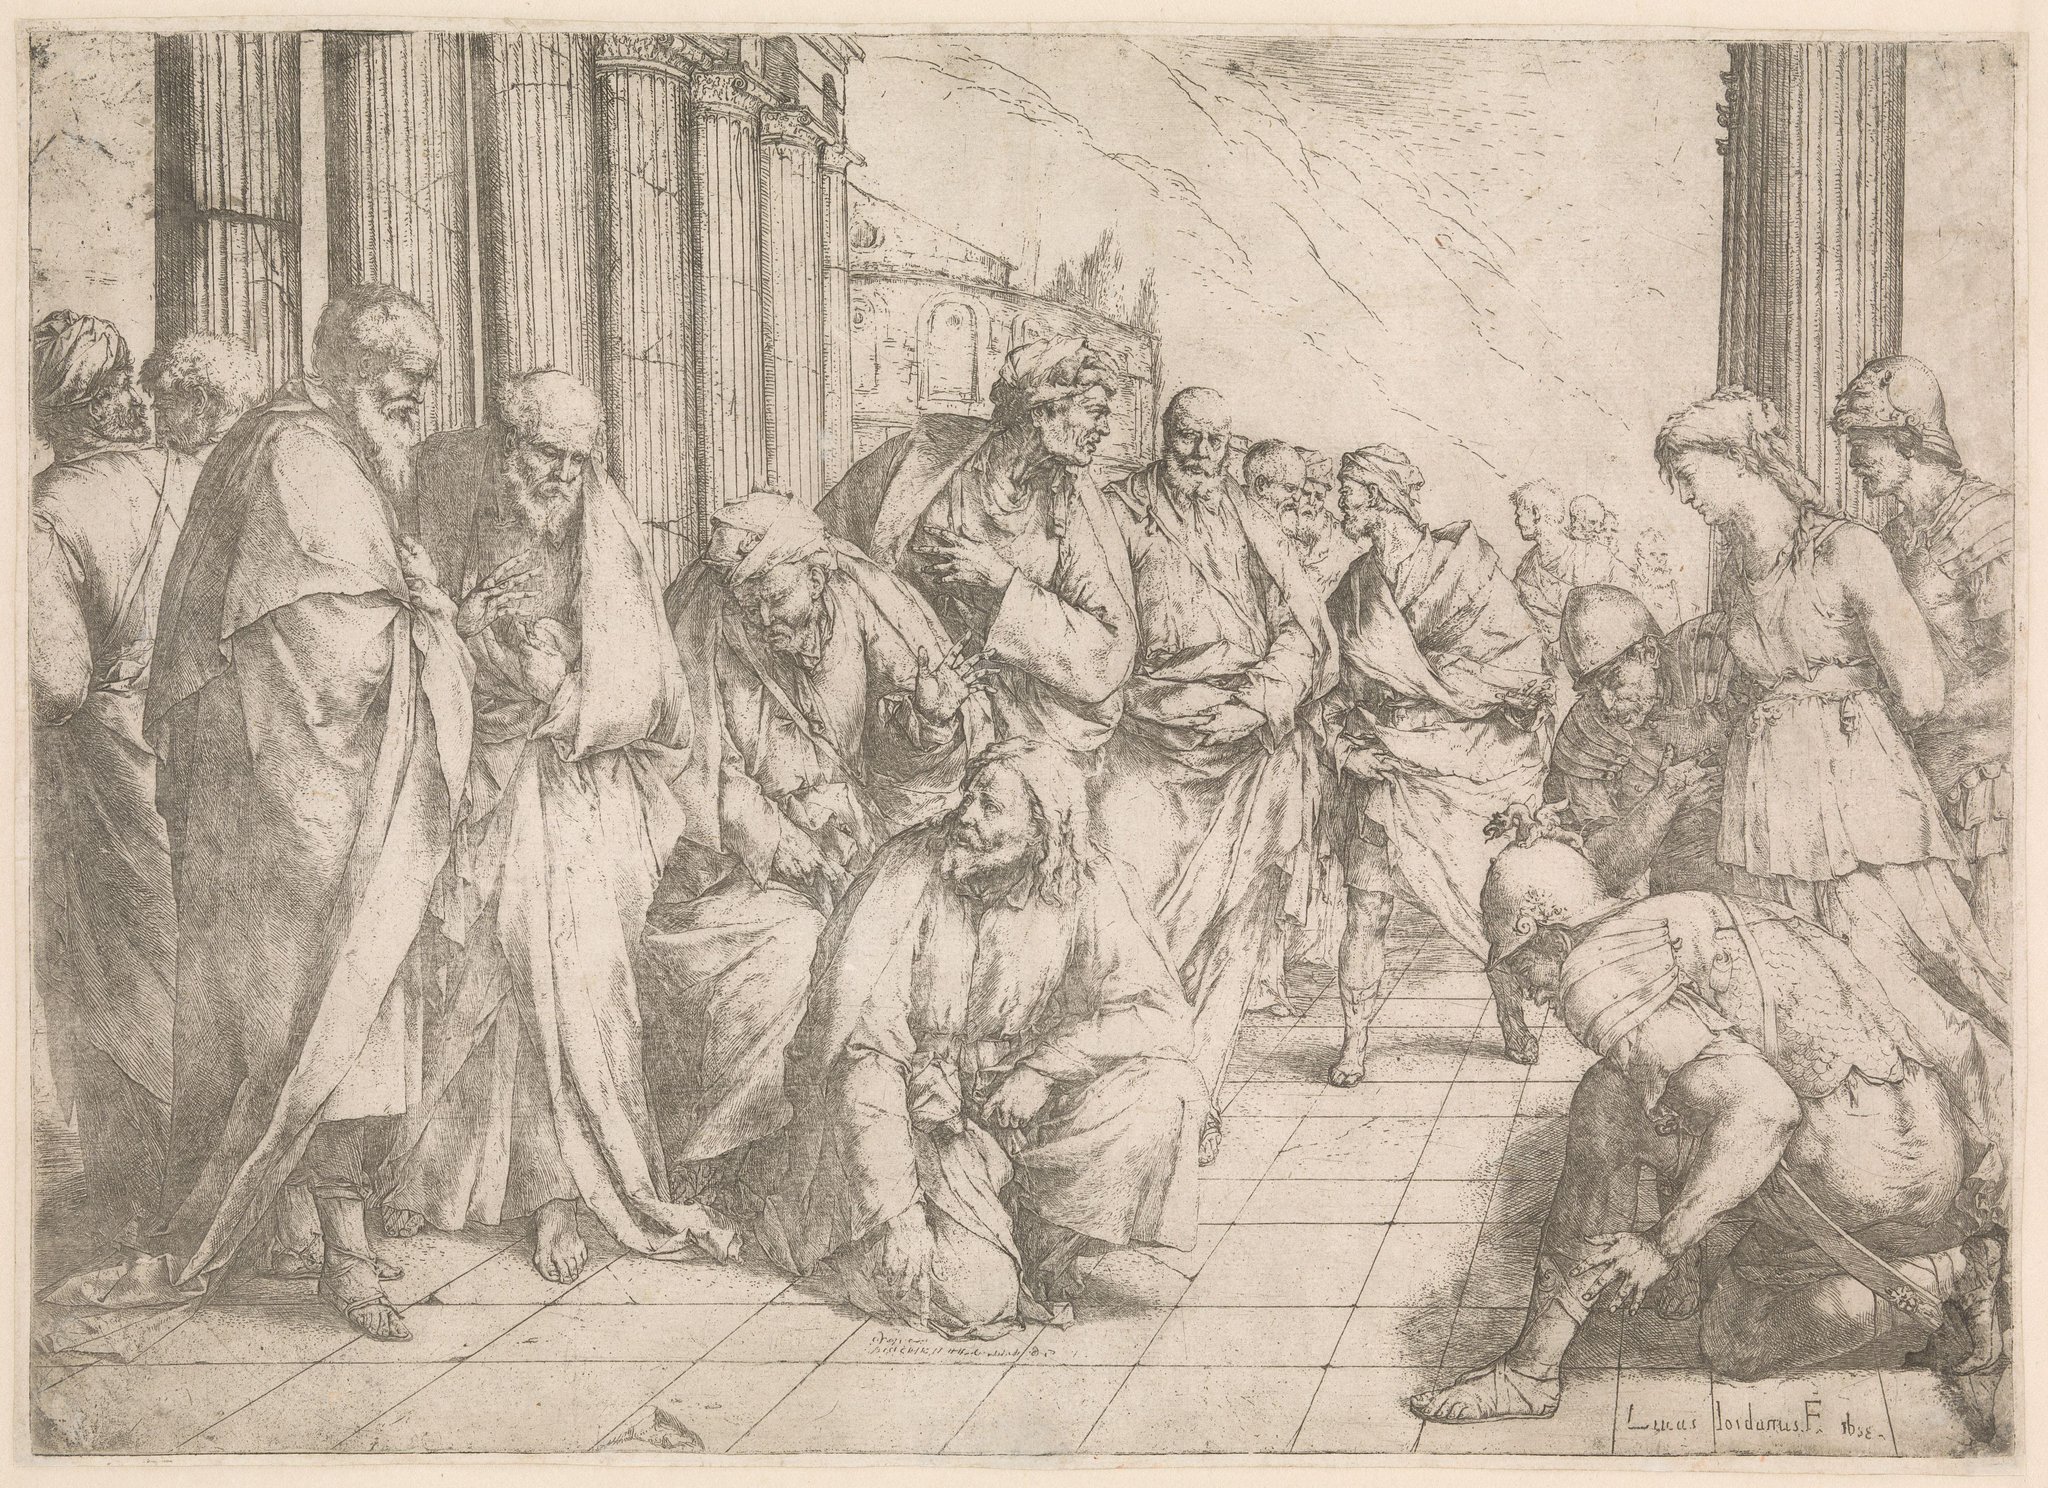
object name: print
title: Christ and the Woman Taken in Adultery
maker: luca giordano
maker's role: draughtsman, painter, print maker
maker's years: 1632-1705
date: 1653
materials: paper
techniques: etching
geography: naples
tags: christ points to or writes on the ground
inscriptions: collector's mark: Lugt 2228, collector's mark: Lugt 2760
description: Hypocritically, Pharisees ask Christ’s opinion of an adulterous woman. He writes his answer on the floor: ‘Let him who is without sin among you be the first to cast a stone at her.’ Giordano drew their anguished faces with great empathy. Because of his delicate technique, the nuances are only visible in the earliest impressions, when they were still crisply etched in the plate. Etching was a new medium for the young artist.